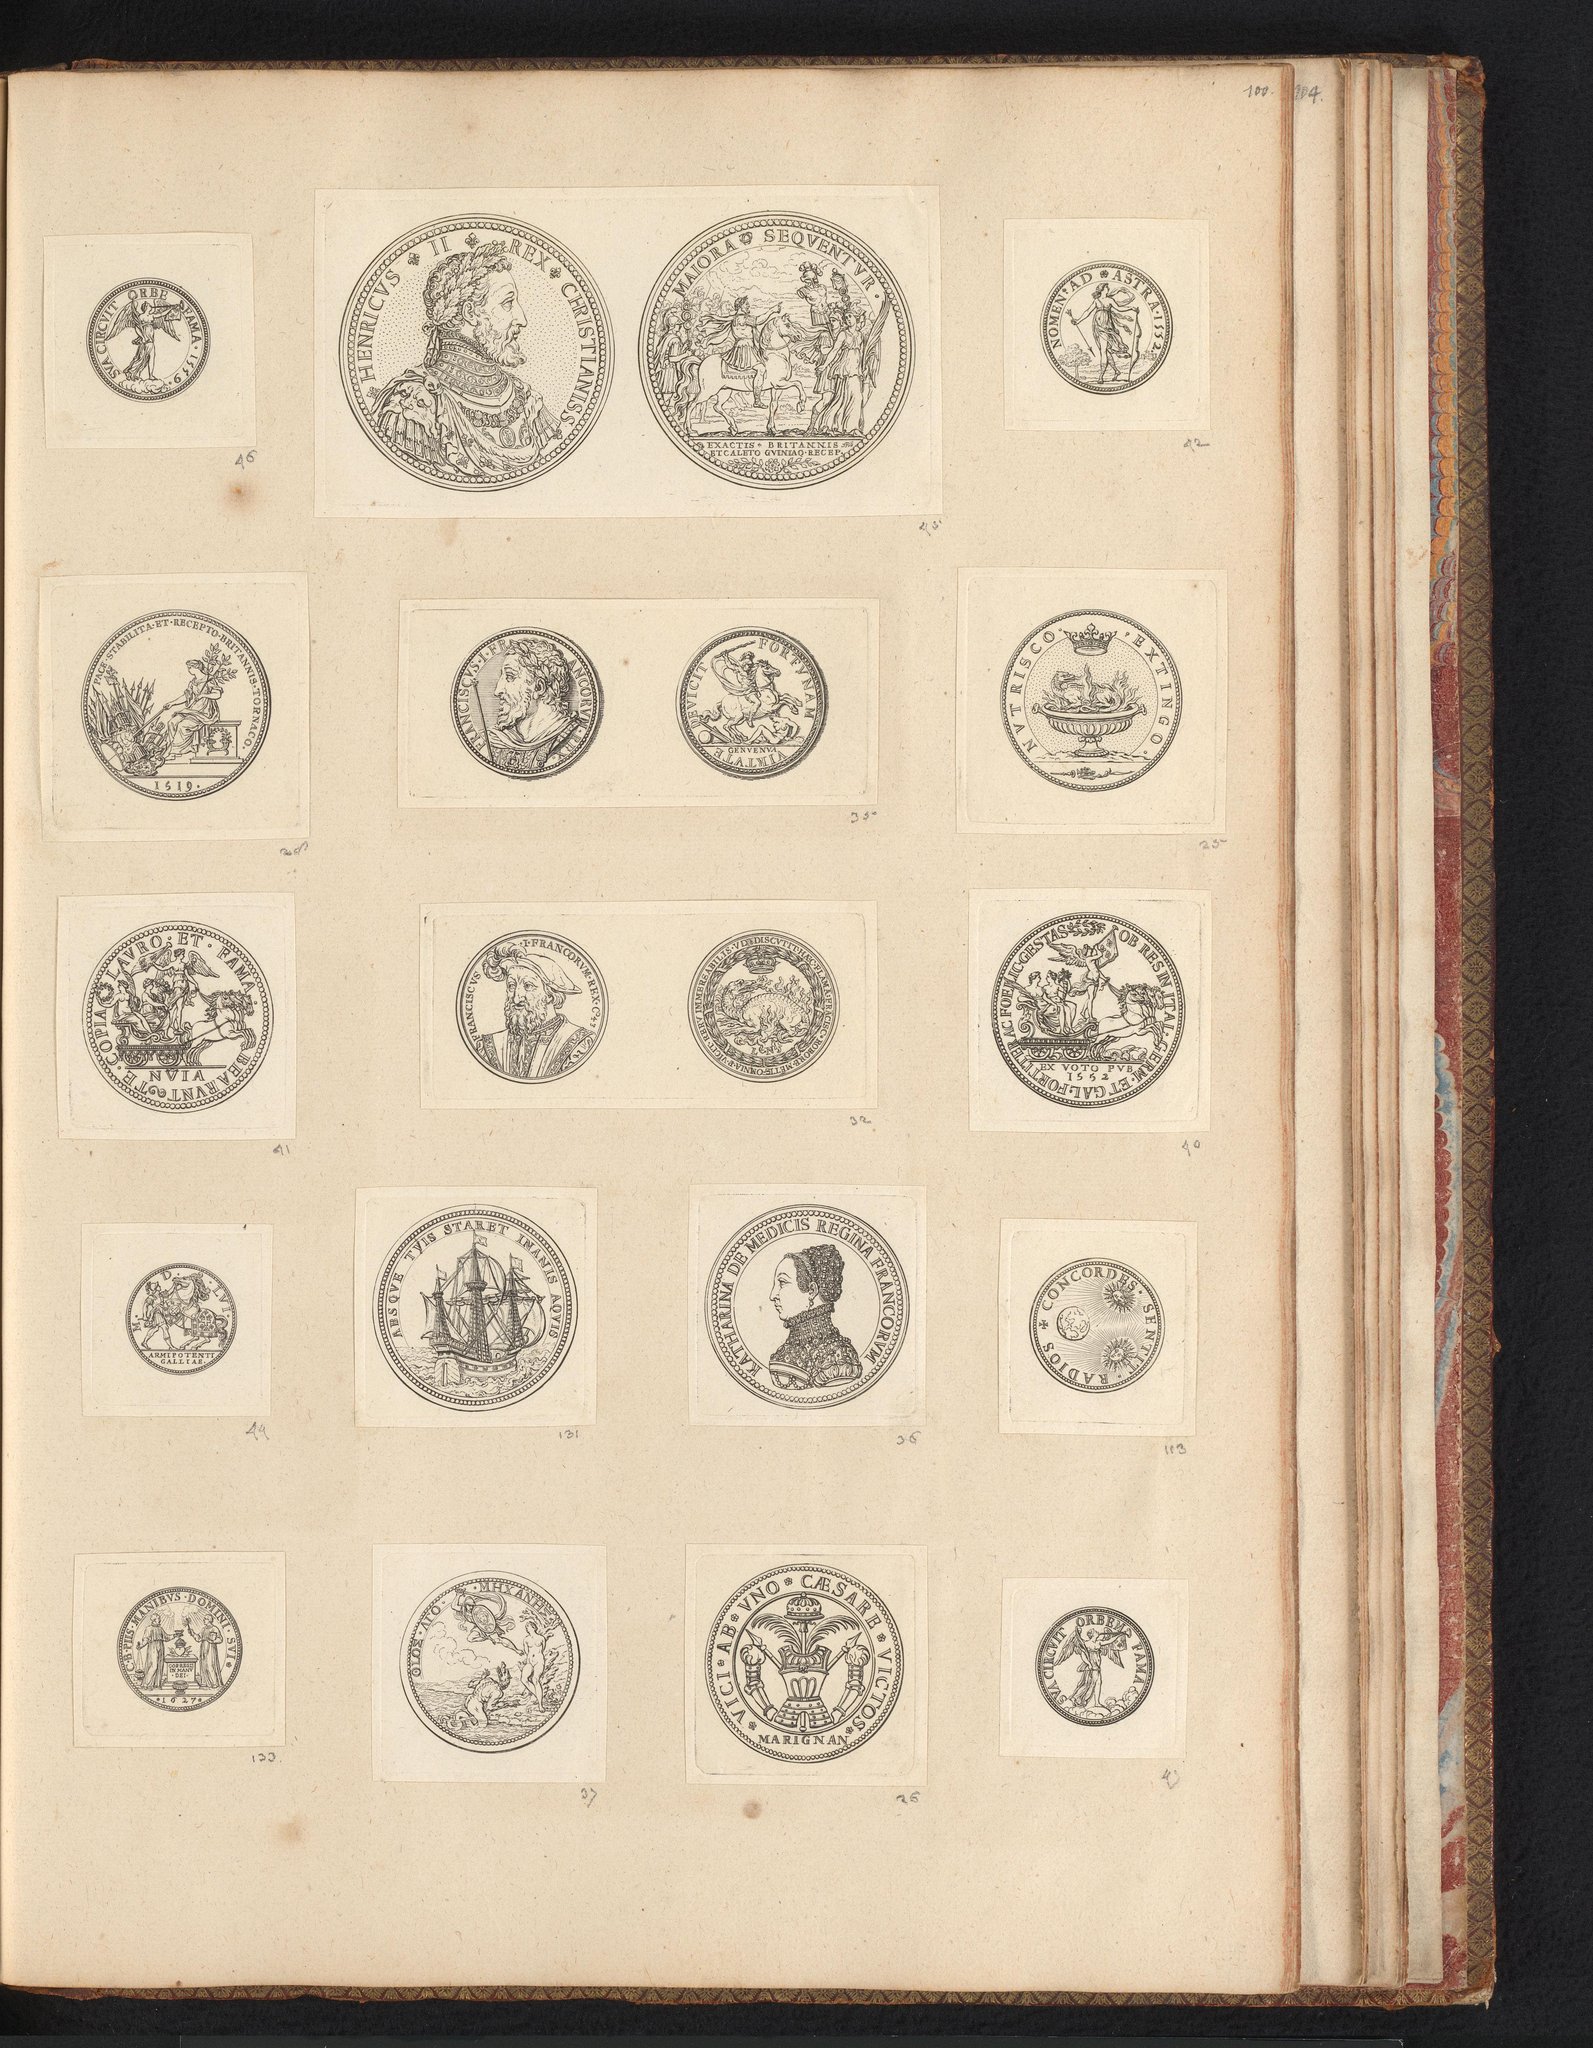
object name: album leaf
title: Médailles relatives à l'histoire de France de Charles VII à Louis XIII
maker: sébastien leclerc (i)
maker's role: print maker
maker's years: 1637-1714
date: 1685-1688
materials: paper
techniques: etching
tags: frans i van valois-angoulême (koning van frankrijk), perseus and andromeda, historical persons, medal (considered as a piece of sculpture, regardless of its specific function), victory, ranks ~ rulers, sovereigns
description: Zeventien medailles met voorstellingen gerelateerd aan de geschiedenis van Frankrijk. Prenten maken deel uit van een album.